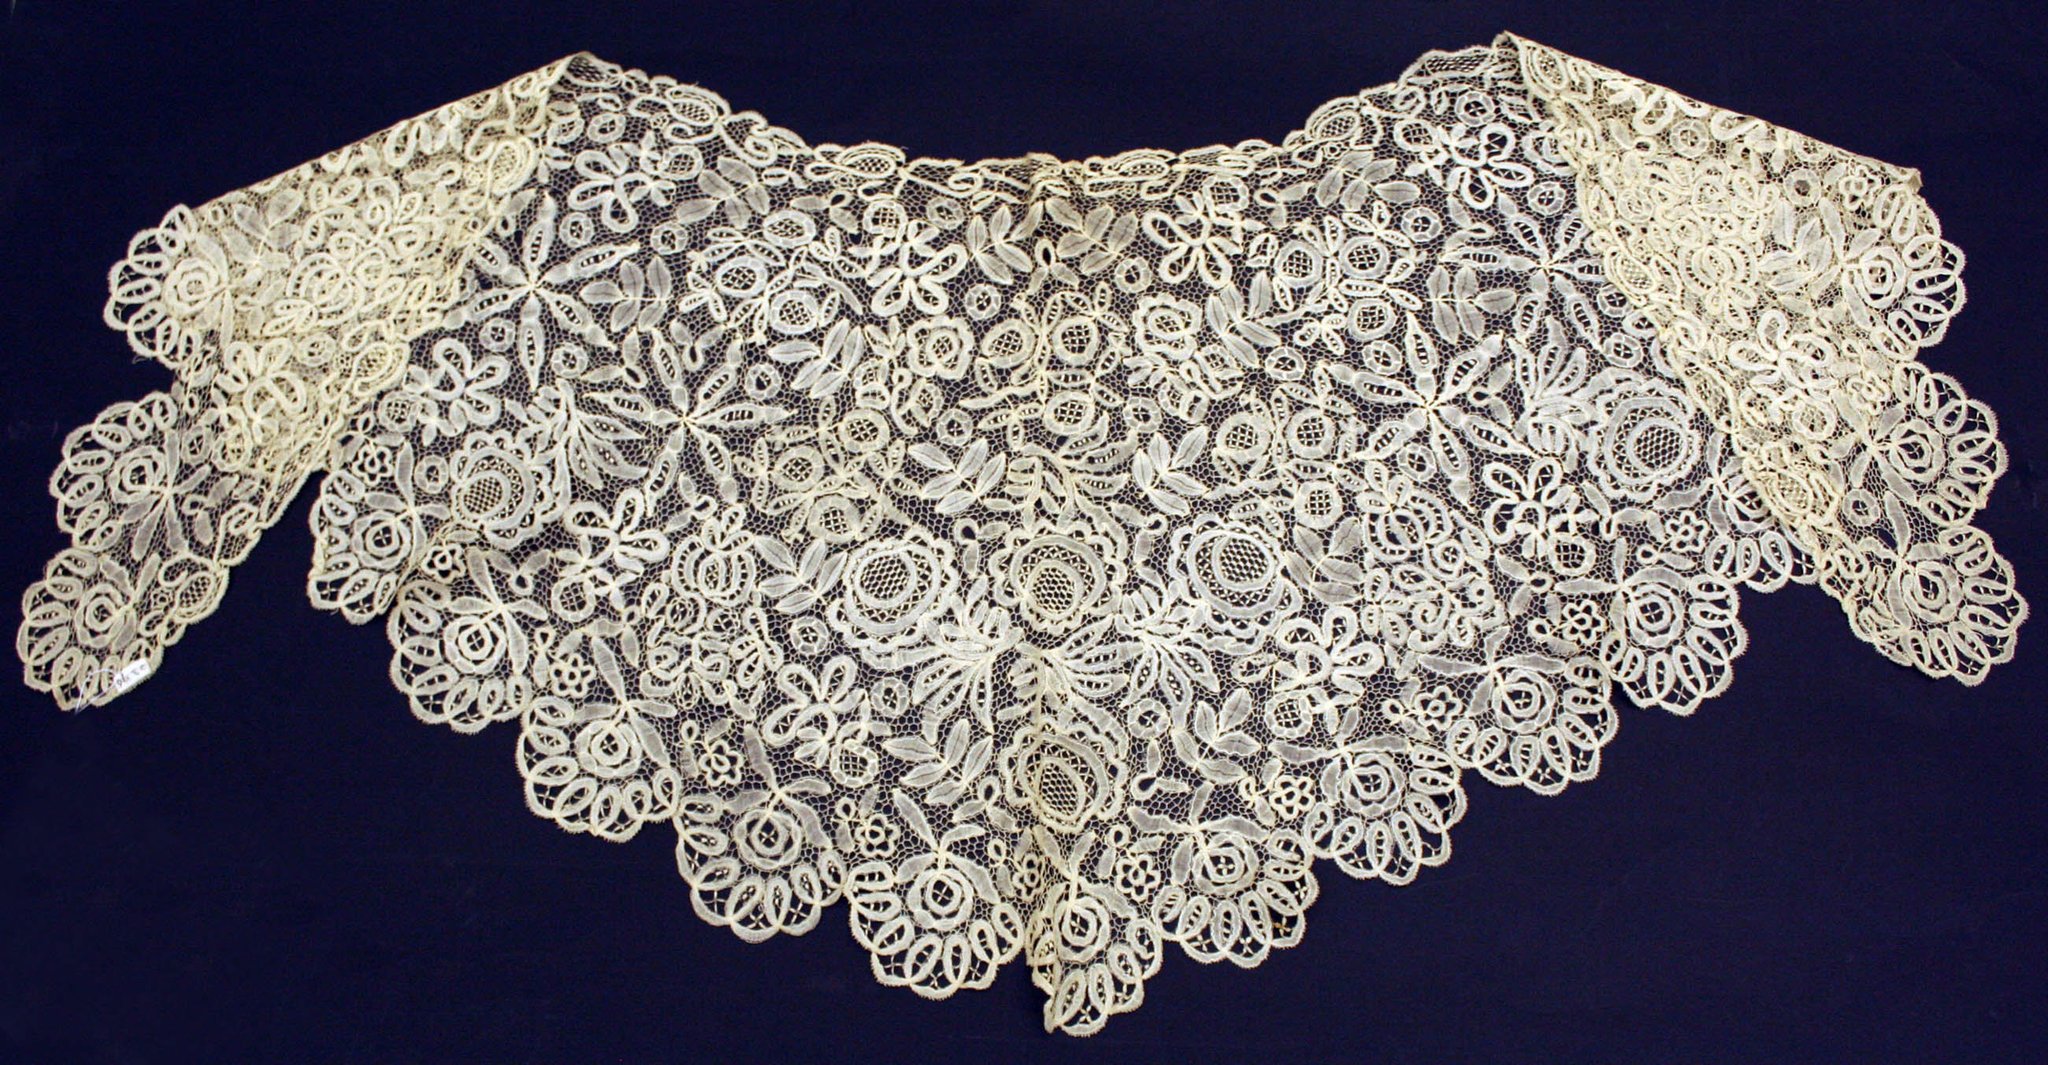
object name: cape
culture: british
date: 1801-1833